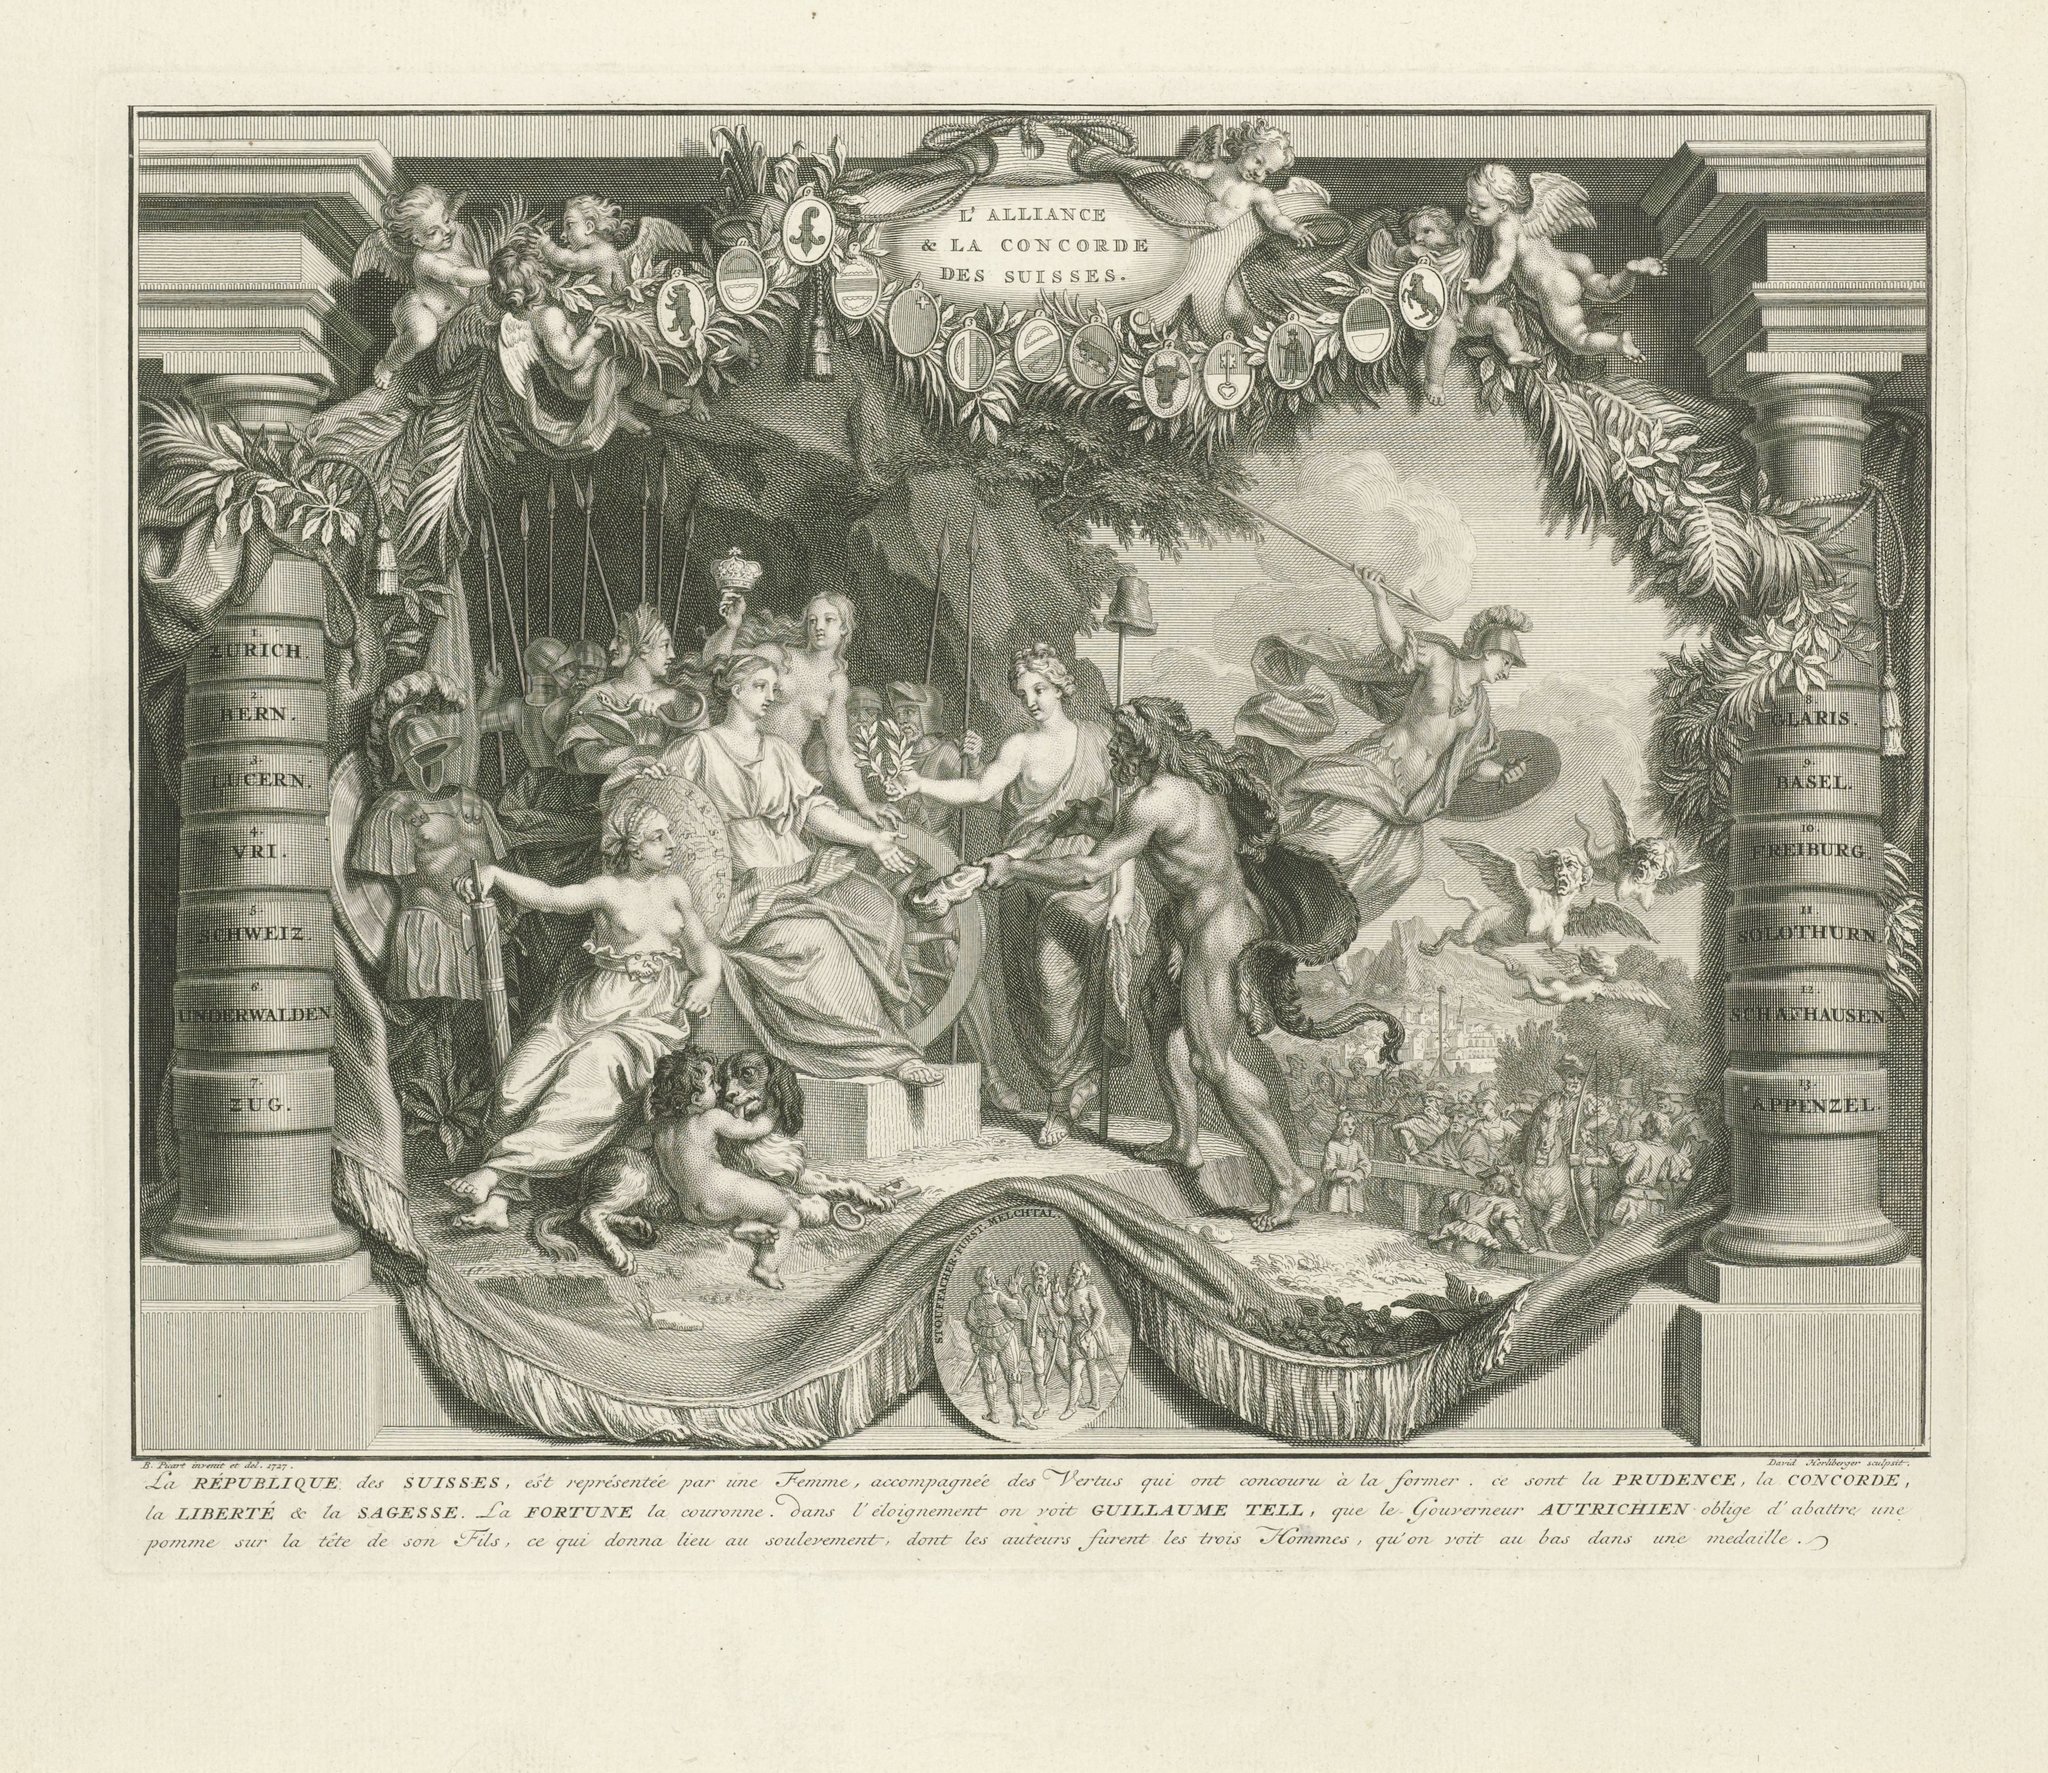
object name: print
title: Allegorie op het verbond en de vrede met Zwitserland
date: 1727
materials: paper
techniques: engraving, etching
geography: amsterdam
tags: (story of) hercules (heracles), agreement, unity; 'concordia', 'concordia insuperabile', 'concordia militare', 'concordia di pace', 'unione civile' (ripa), prudence, 'prudentia'; 'prudenza' (ripa) ~ one of the four cardinal virtues, personifications of countries, nations, states, districts, etc., (story of) minerva (pallas, athena), wisdom; 'sapienza', 'sapienza humana', 'sapienza vera' (ripa), luck, fortune, lot; 'fato', 'fortuna', 'fortuna aurea', 'fortuna buona', 'fortuna pacifica overo clemente', 'sorte' (ripa), harpy (fabulous bird); 'arpie' (ripa), freedom, liberty; 'libertà' (ripa), switzerland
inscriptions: collector's mark: Lugt 240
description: Hercules biedt de personificatie van de Republiek van Zwitserland zijn knots aan. Zij is omringd door personificaties van de deugden: Voorzichtigheid, Eendracht, Vrijheid, Wijsheid en Fortuna. Rechts Minerva die harpijen verjaagt. Rechts op de achtergrond de Zwitserse kruisboogschutter Willem Tell die werd opgedragen met zijn boog een appel van het hoofd van zijn zoon te schieten nadat hij weigerde de hoed te groeten die landvoogd Gessler op een staak op het dorpsplein had laten zetten als symbool voor de heersende Habsburg. De voorstelling wordt omlijst door twee pilaren waarop een opsomming van Zwitserse steden en een guirlande waaraan wapenschilden. In de marge een drieregelig onderschrift in het Frans.